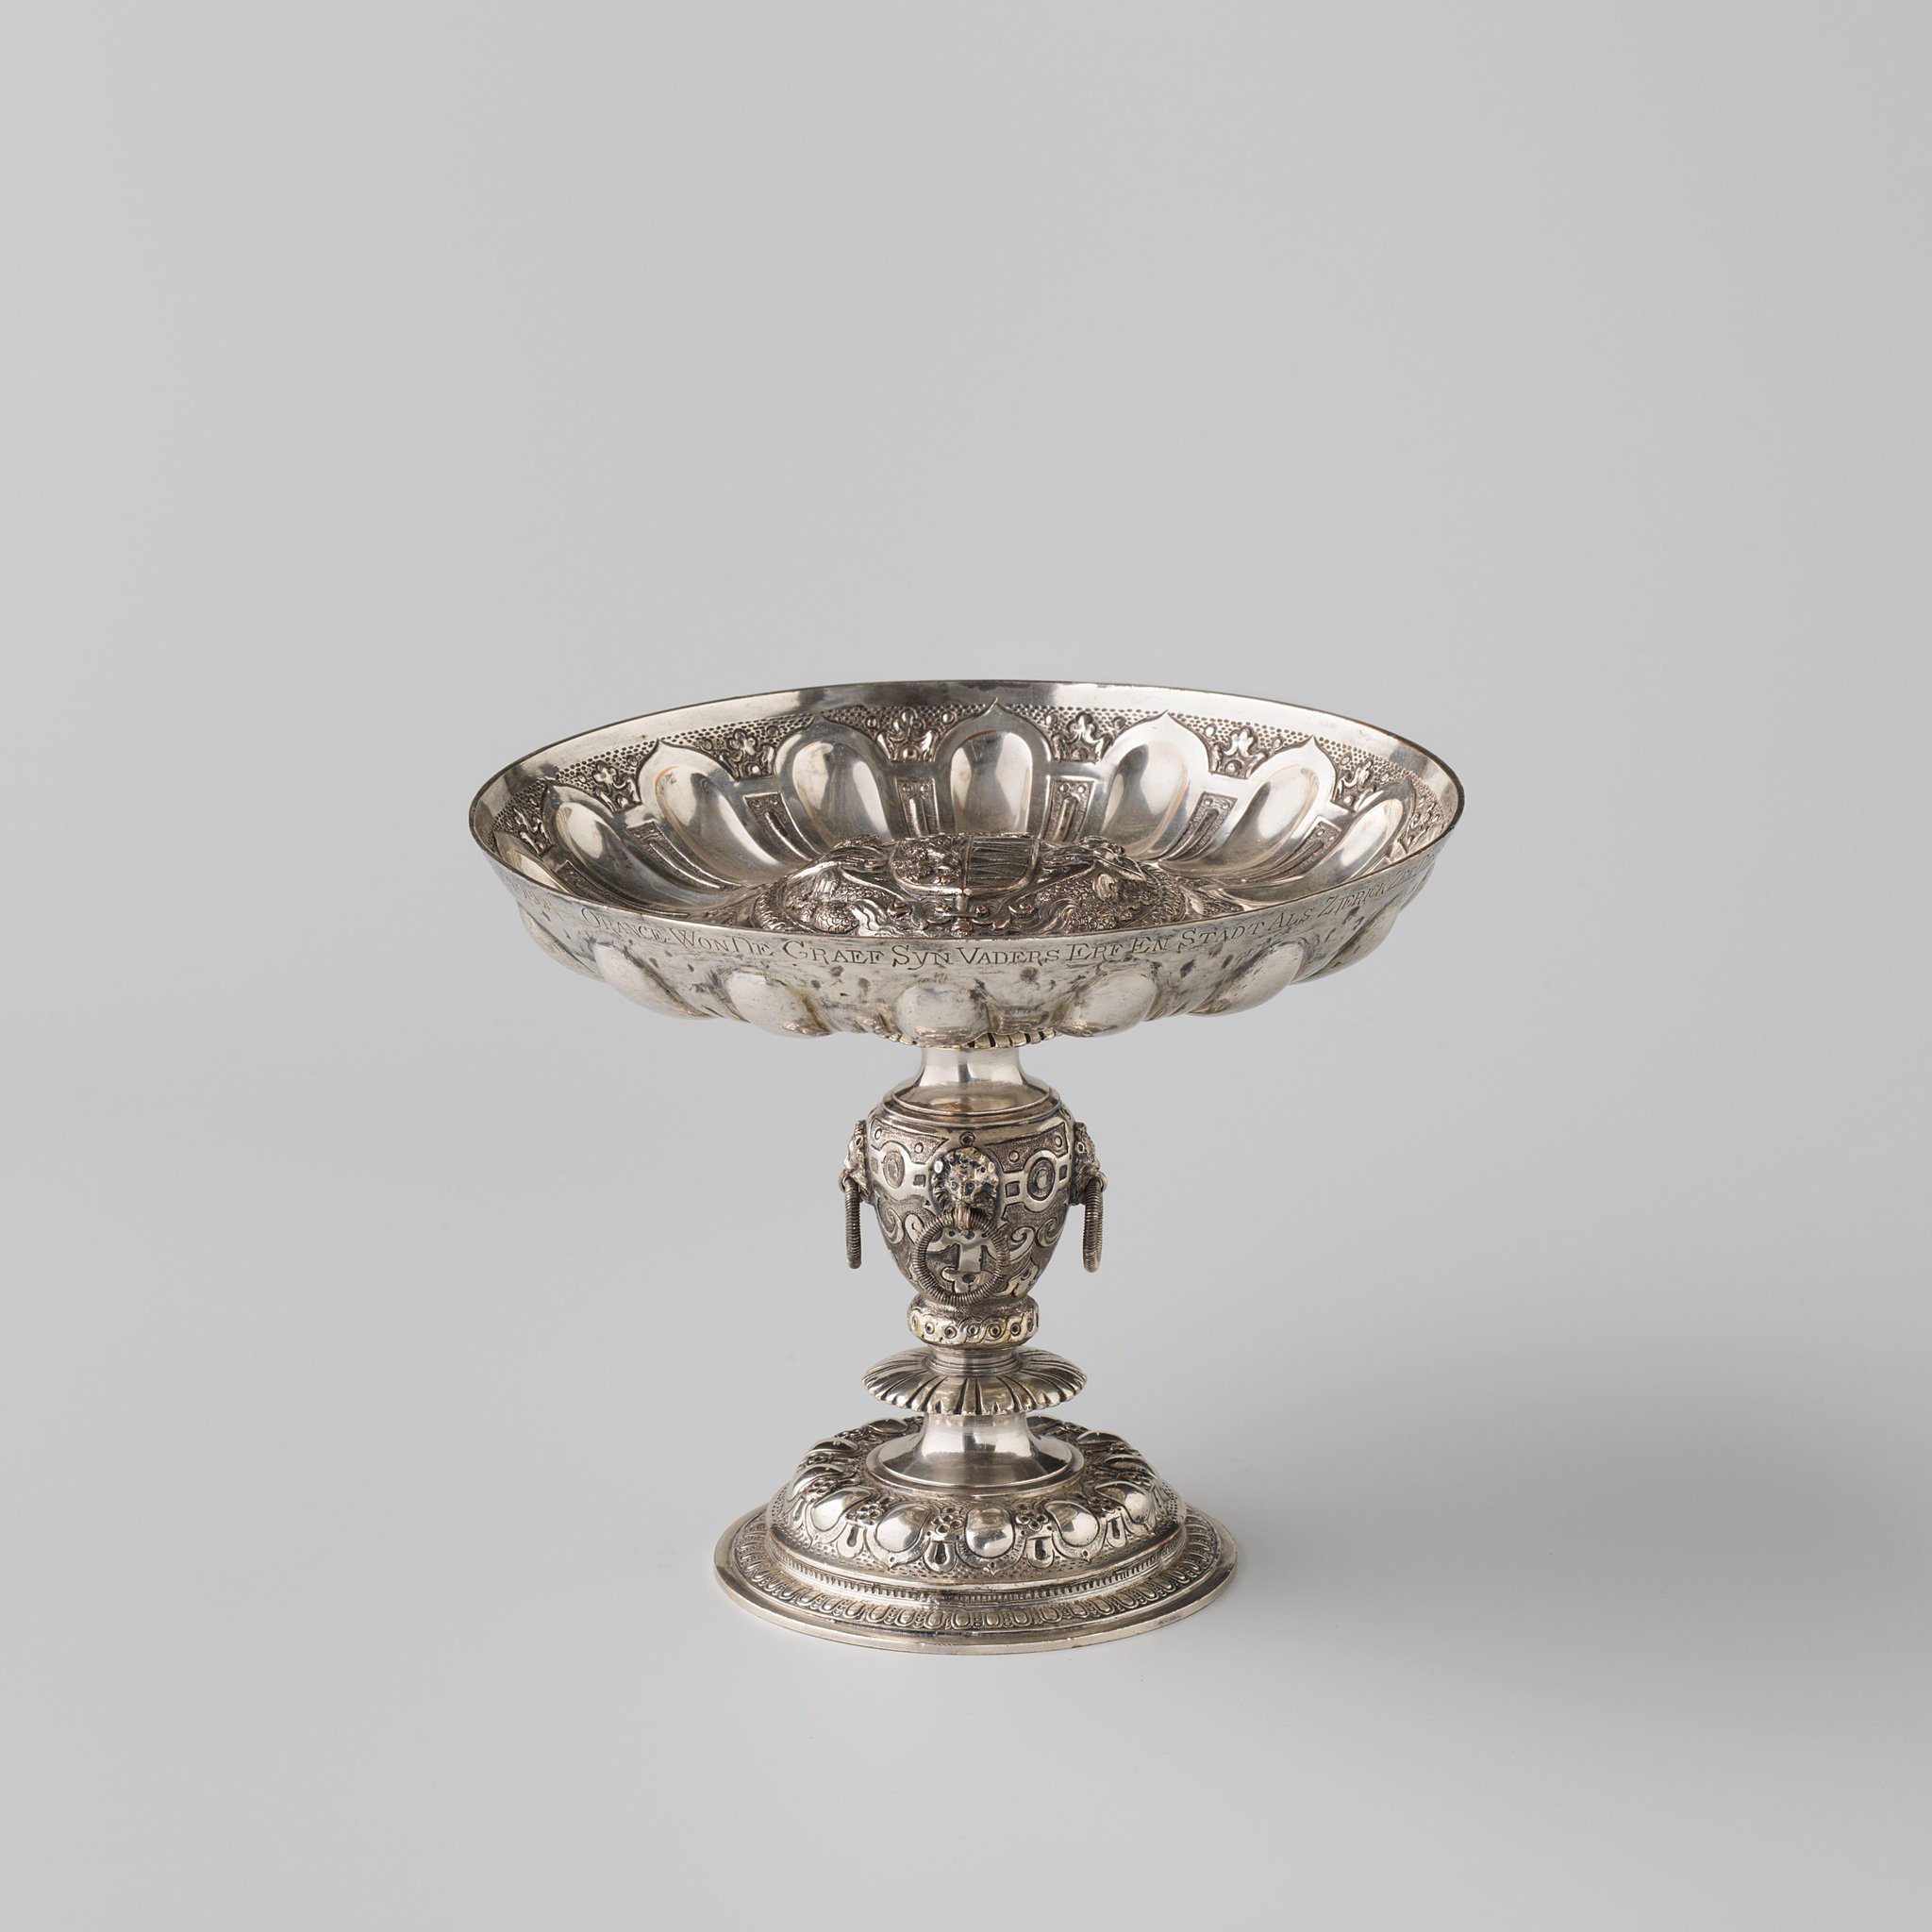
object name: dish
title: Galvanoplastische reproductie van een drinkschaal met op het plat het wapen van Zierikzee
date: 1881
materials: copper, silver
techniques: galvanoplasty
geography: london